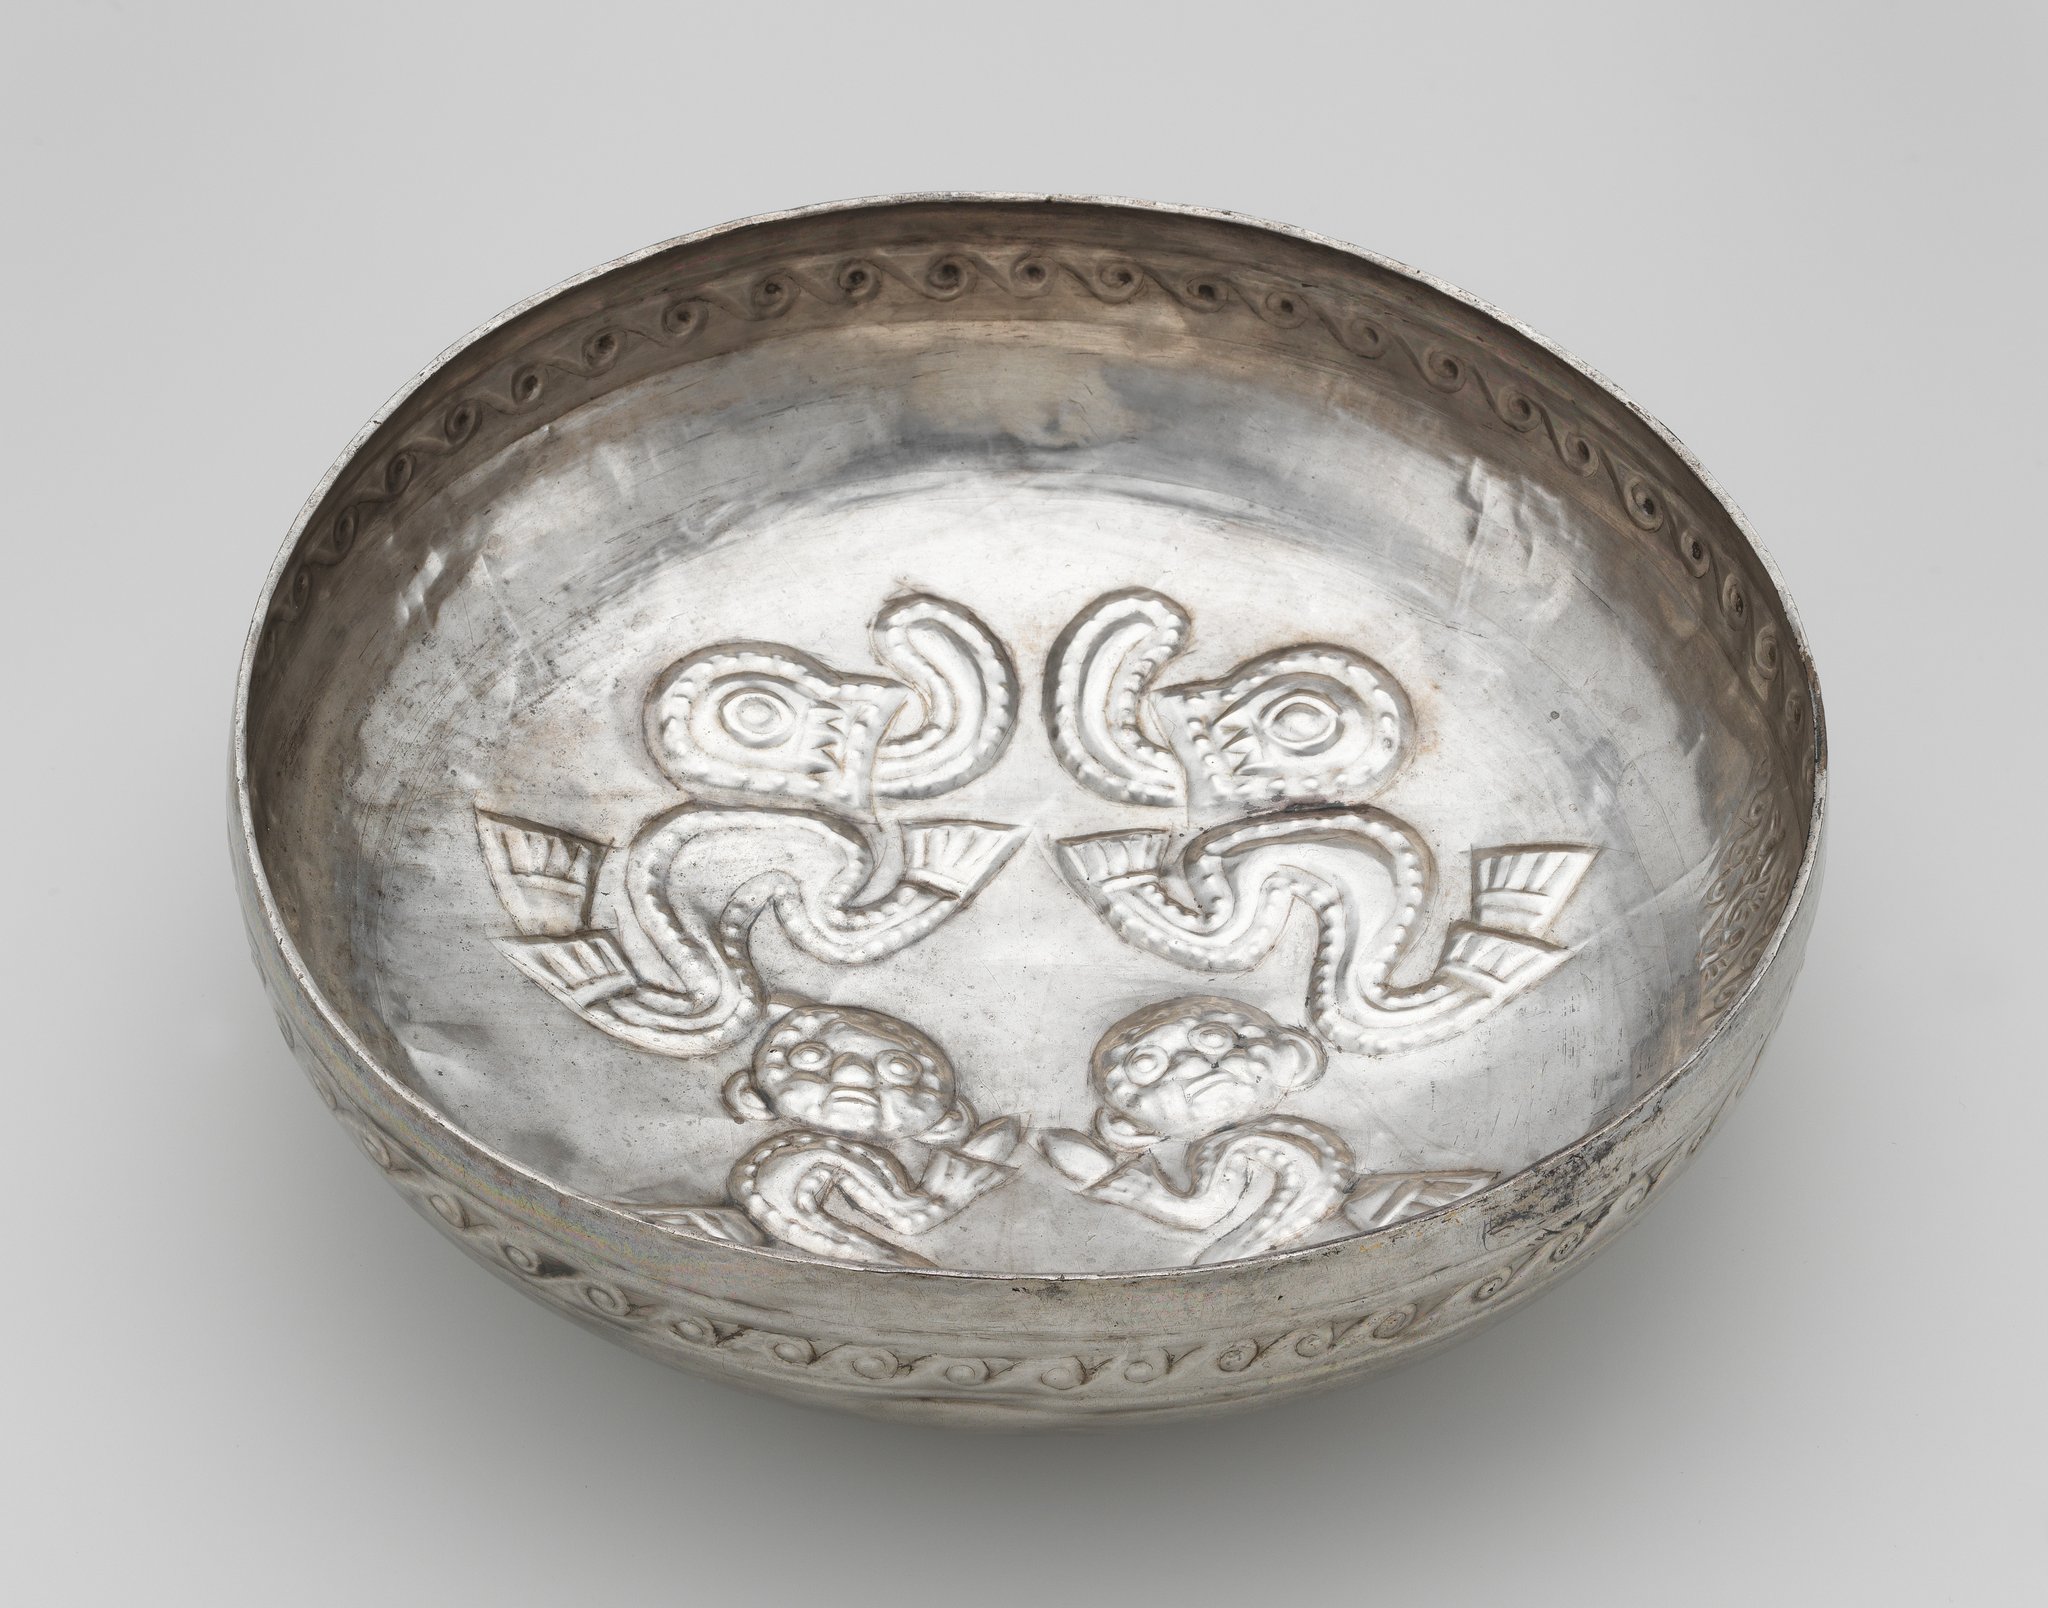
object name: bowl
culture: chimú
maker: chimú artist(s)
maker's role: artist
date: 1000-1470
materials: silver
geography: peru